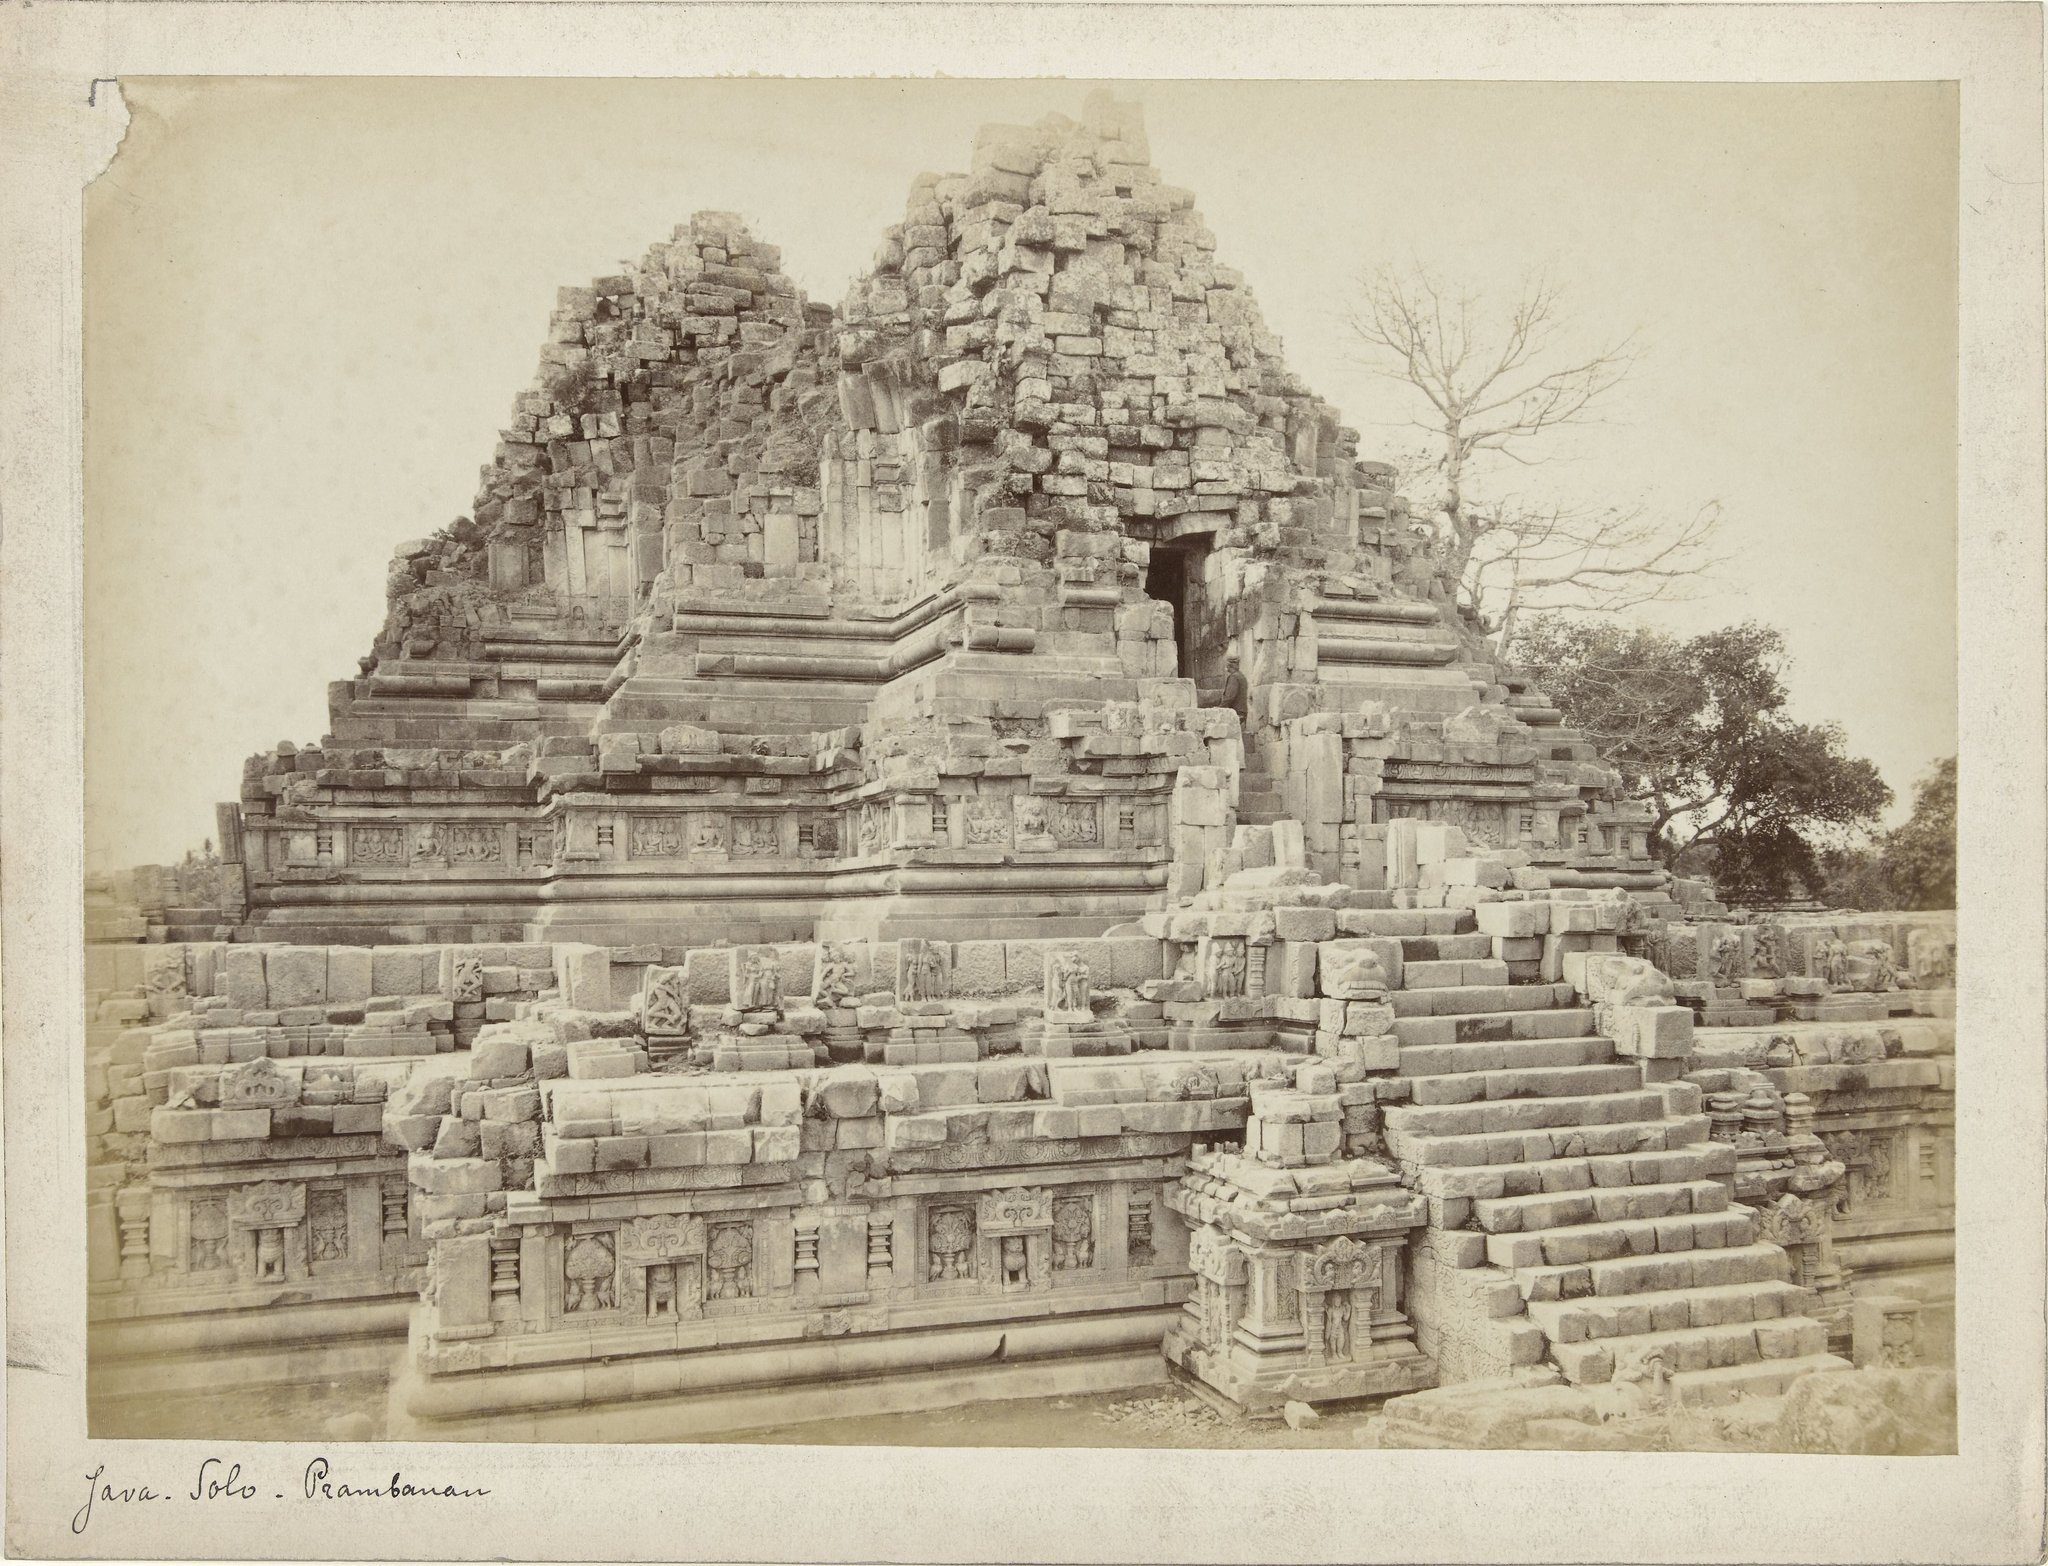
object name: photograph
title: Java. Solo. Prambanan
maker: kassian céphas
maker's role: fotograaf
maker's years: 1845-1912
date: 1889-1890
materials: cardboard, paper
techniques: albumen print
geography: prambanan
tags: temple, shrine ~ hinduism, buddhism, jainism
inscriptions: number: ‘53’, inscription: ‘Java. Solo. Prambanan’